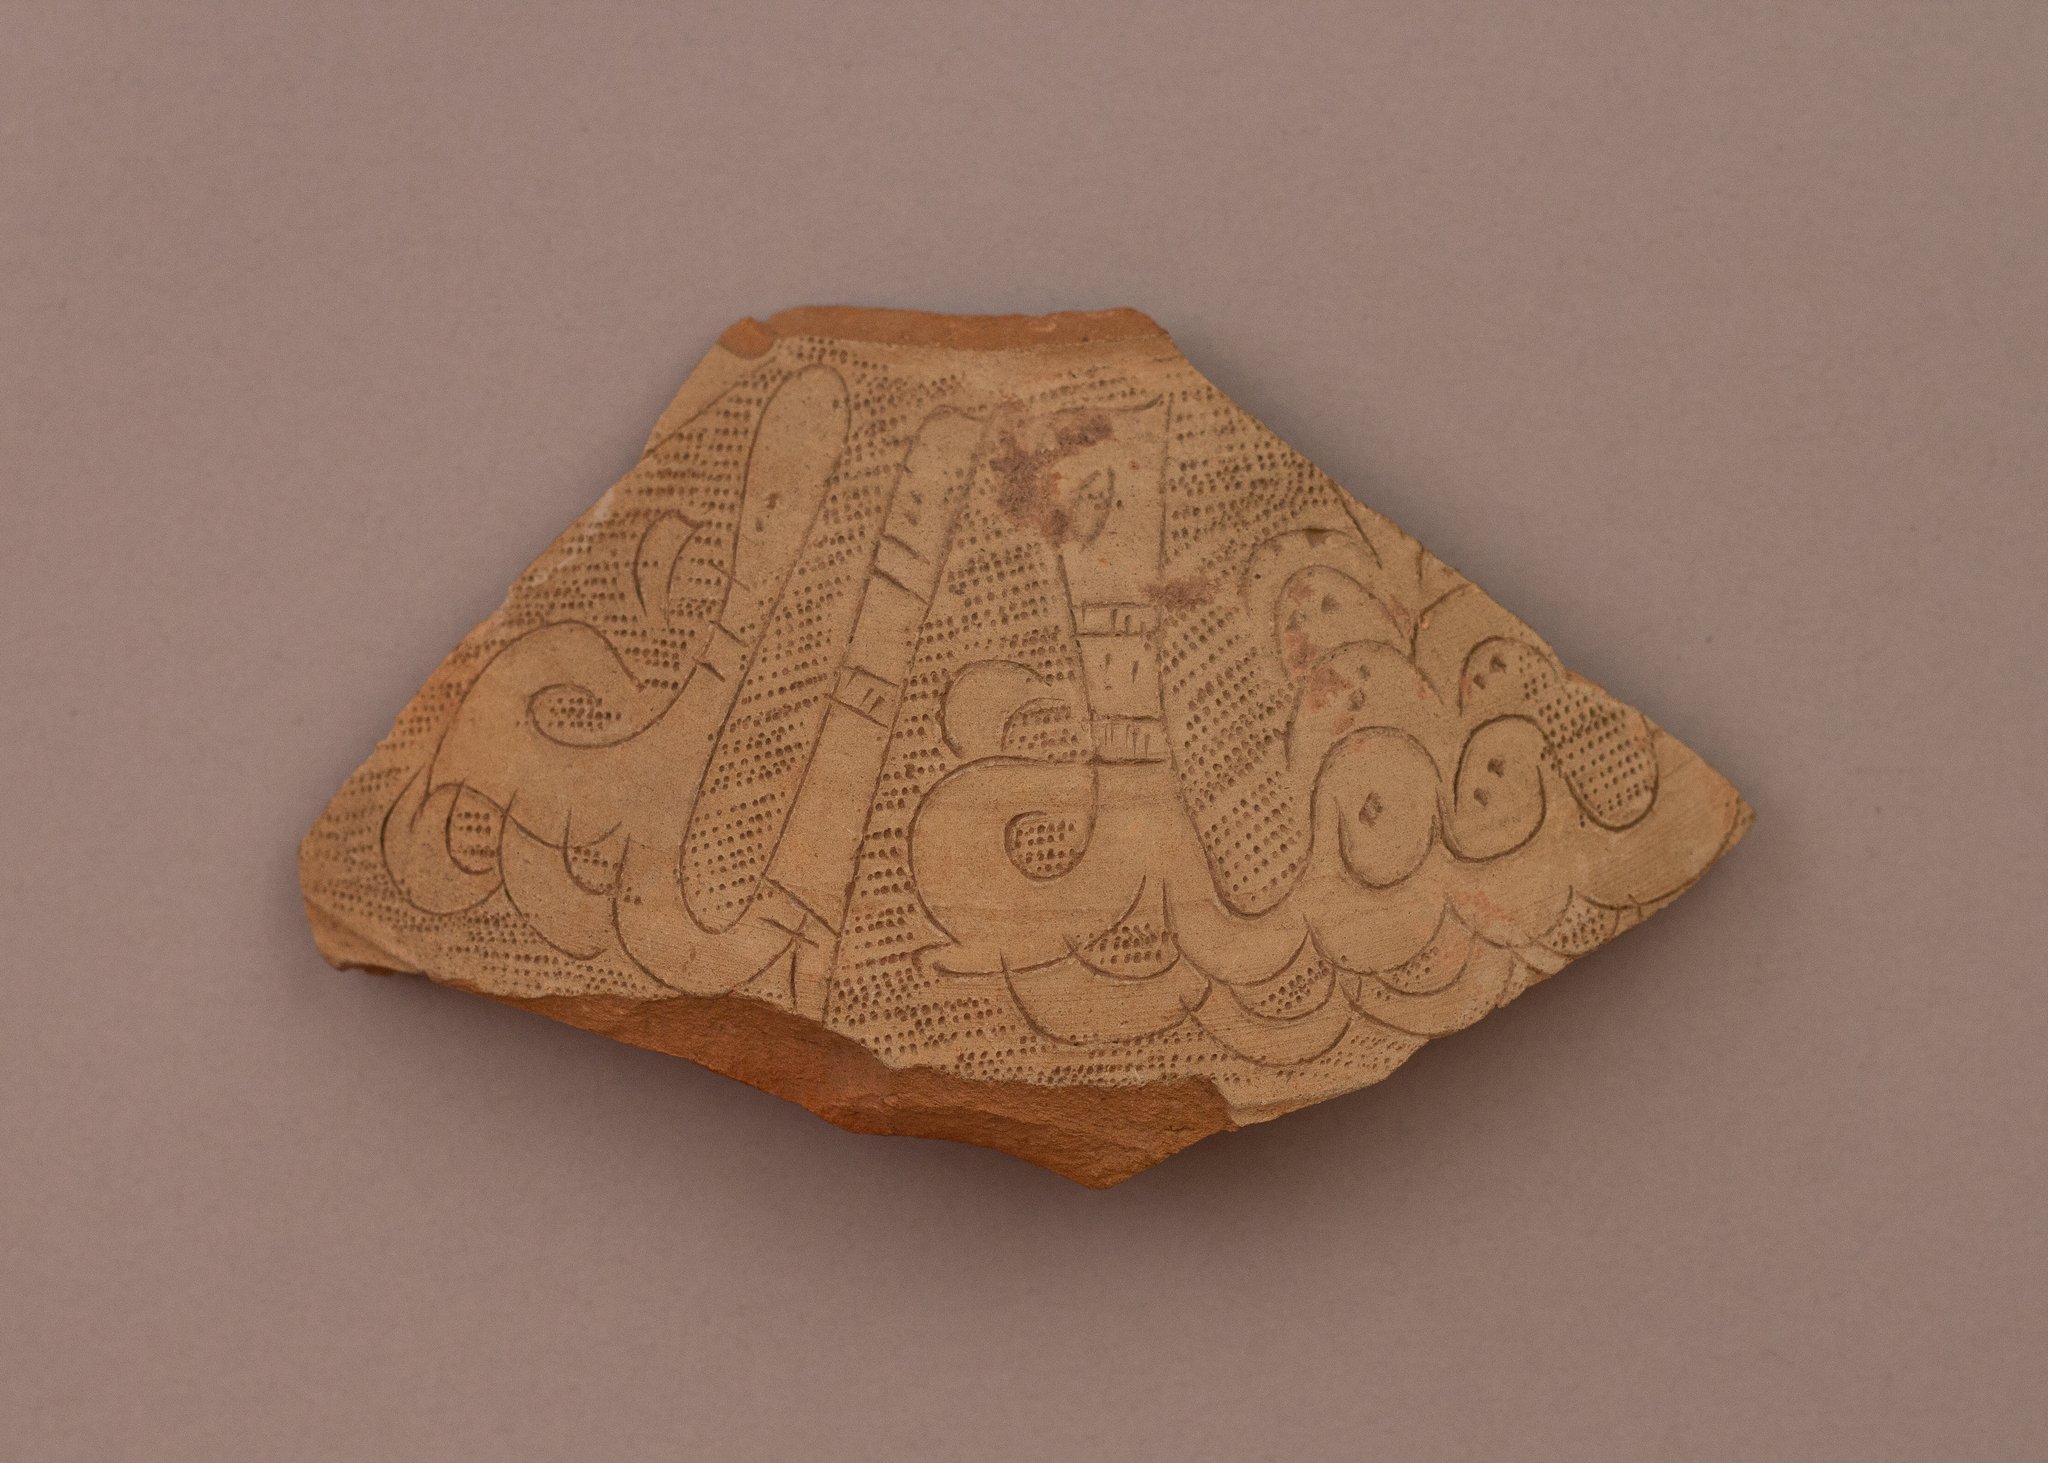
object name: fragment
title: Ceramic Fragment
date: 1001-1200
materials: earthenware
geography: iran